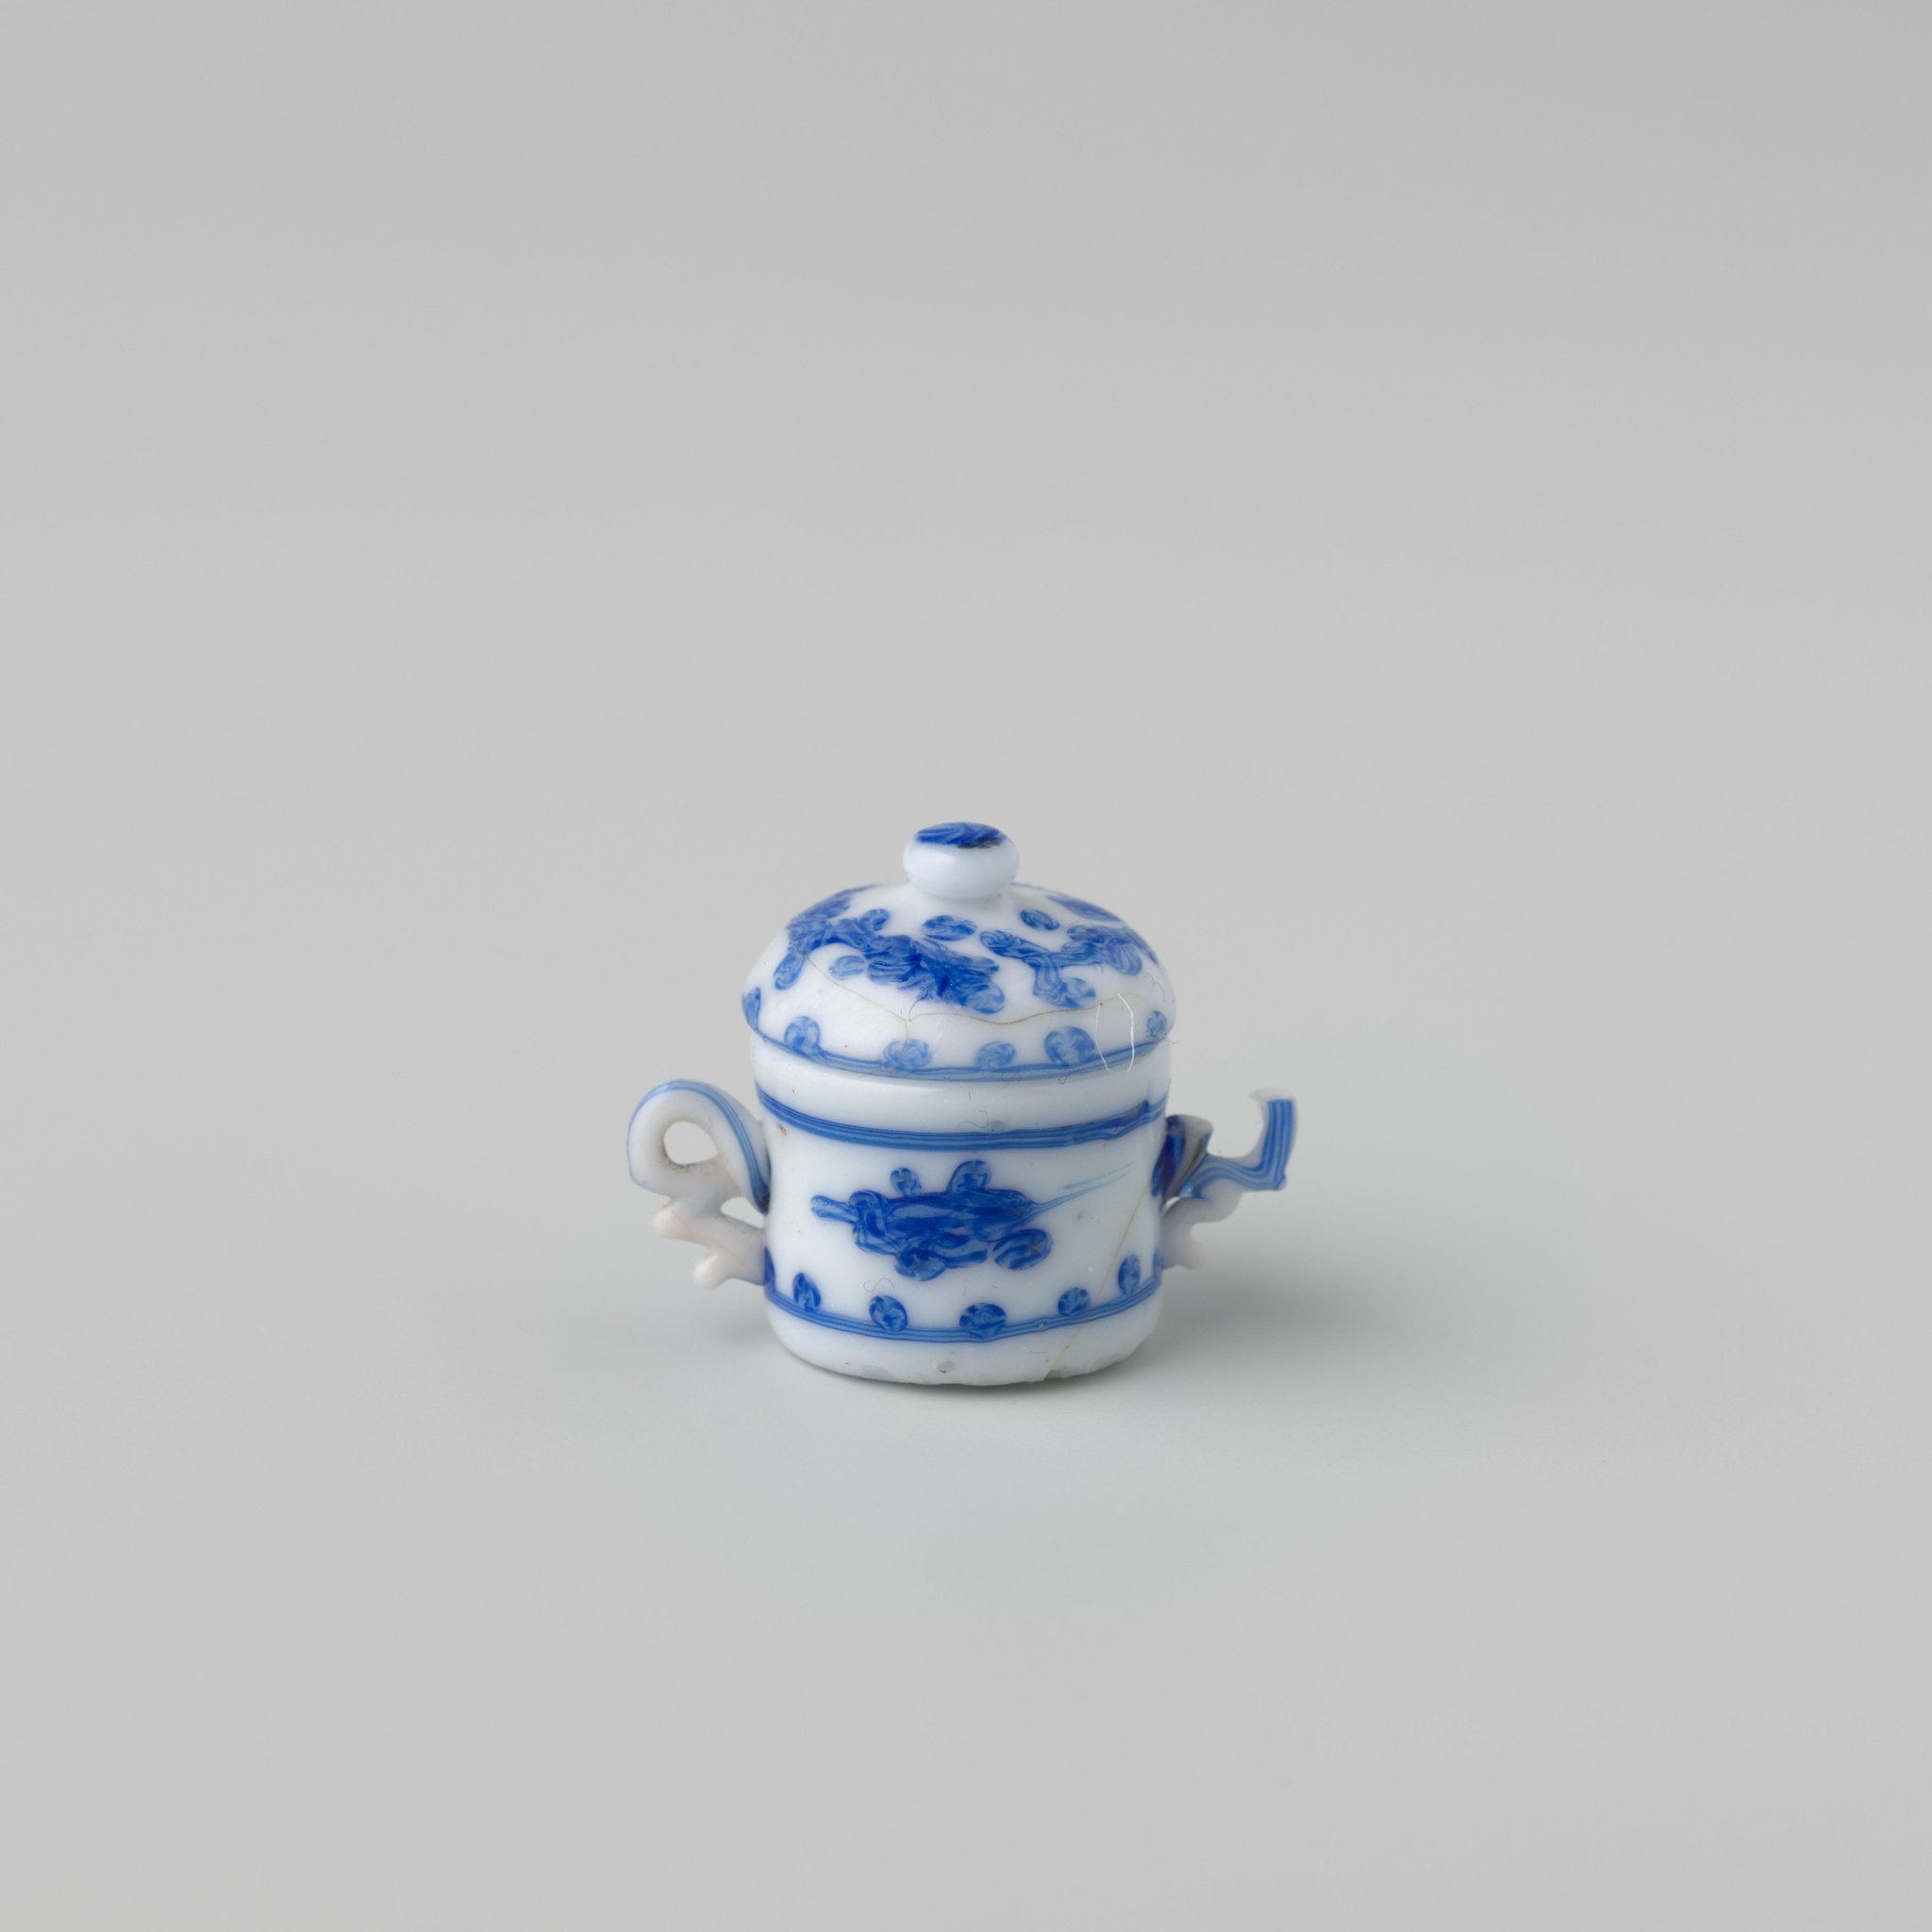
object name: miniature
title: Pot met deksel van melkglas met blauwe emailverf beschildering, imitatie Chinees porselein; cilindrisch lage pot met 2 oren, bolle deksel met knop, stippen en bloemmotieven.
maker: Anonymous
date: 1675-1710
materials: glass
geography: amsterdam